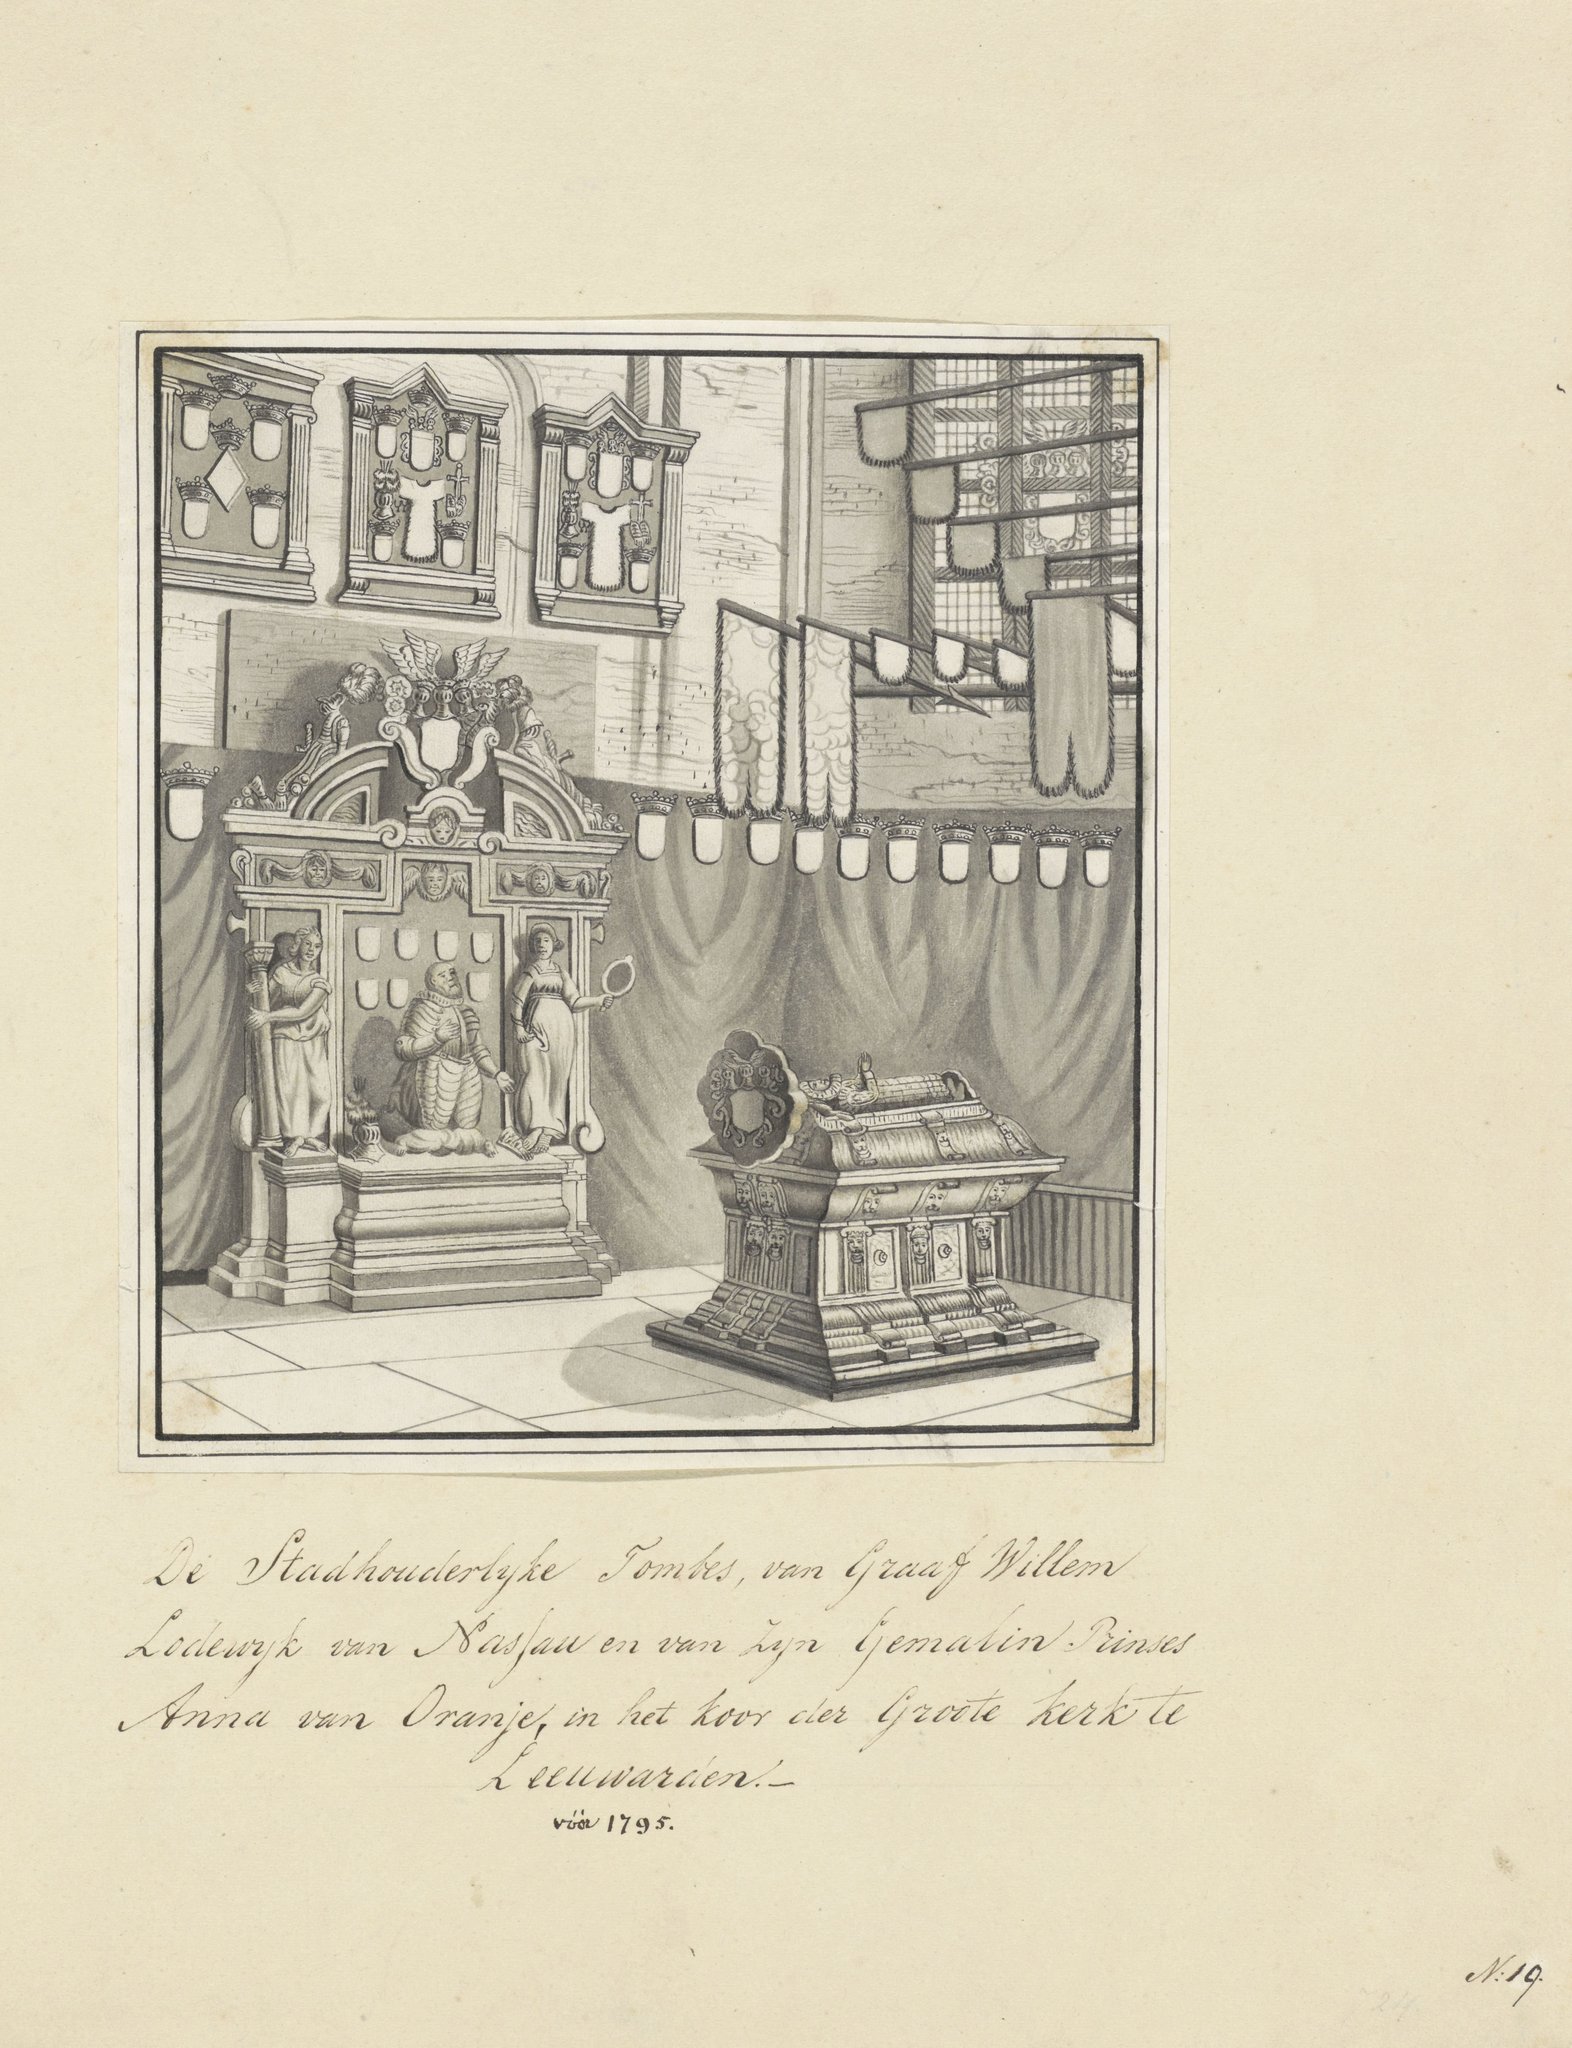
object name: drawing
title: Grafmonument voor Willem Lodewijk, graaf van Nassau-Dillenburg, 1620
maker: Anonymous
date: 1700-1799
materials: ink, paper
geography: low countries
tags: willem lodewijk graaf van nassau-dillenburg, fortitude, 'fortitudo' ~ one of the four cardinal virtues, prudence, 'prudentia'; 'prudenza' (ripa) ~ one of the four cardinal virtues, grave-building, monumental tomb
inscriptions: inscription: ‘De Stadhouderlyke Tombes ... te Leeuwarden. voor 1795.’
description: Grafmonument voor Willem Lodewijk in de Grote Kerk te Leeuwarden, overleden 31 mei 1620, begraven op 13 juli 1620. Gezien van voren met het beeld van de knielende graaf tussen Fortitudo en Prudentia.